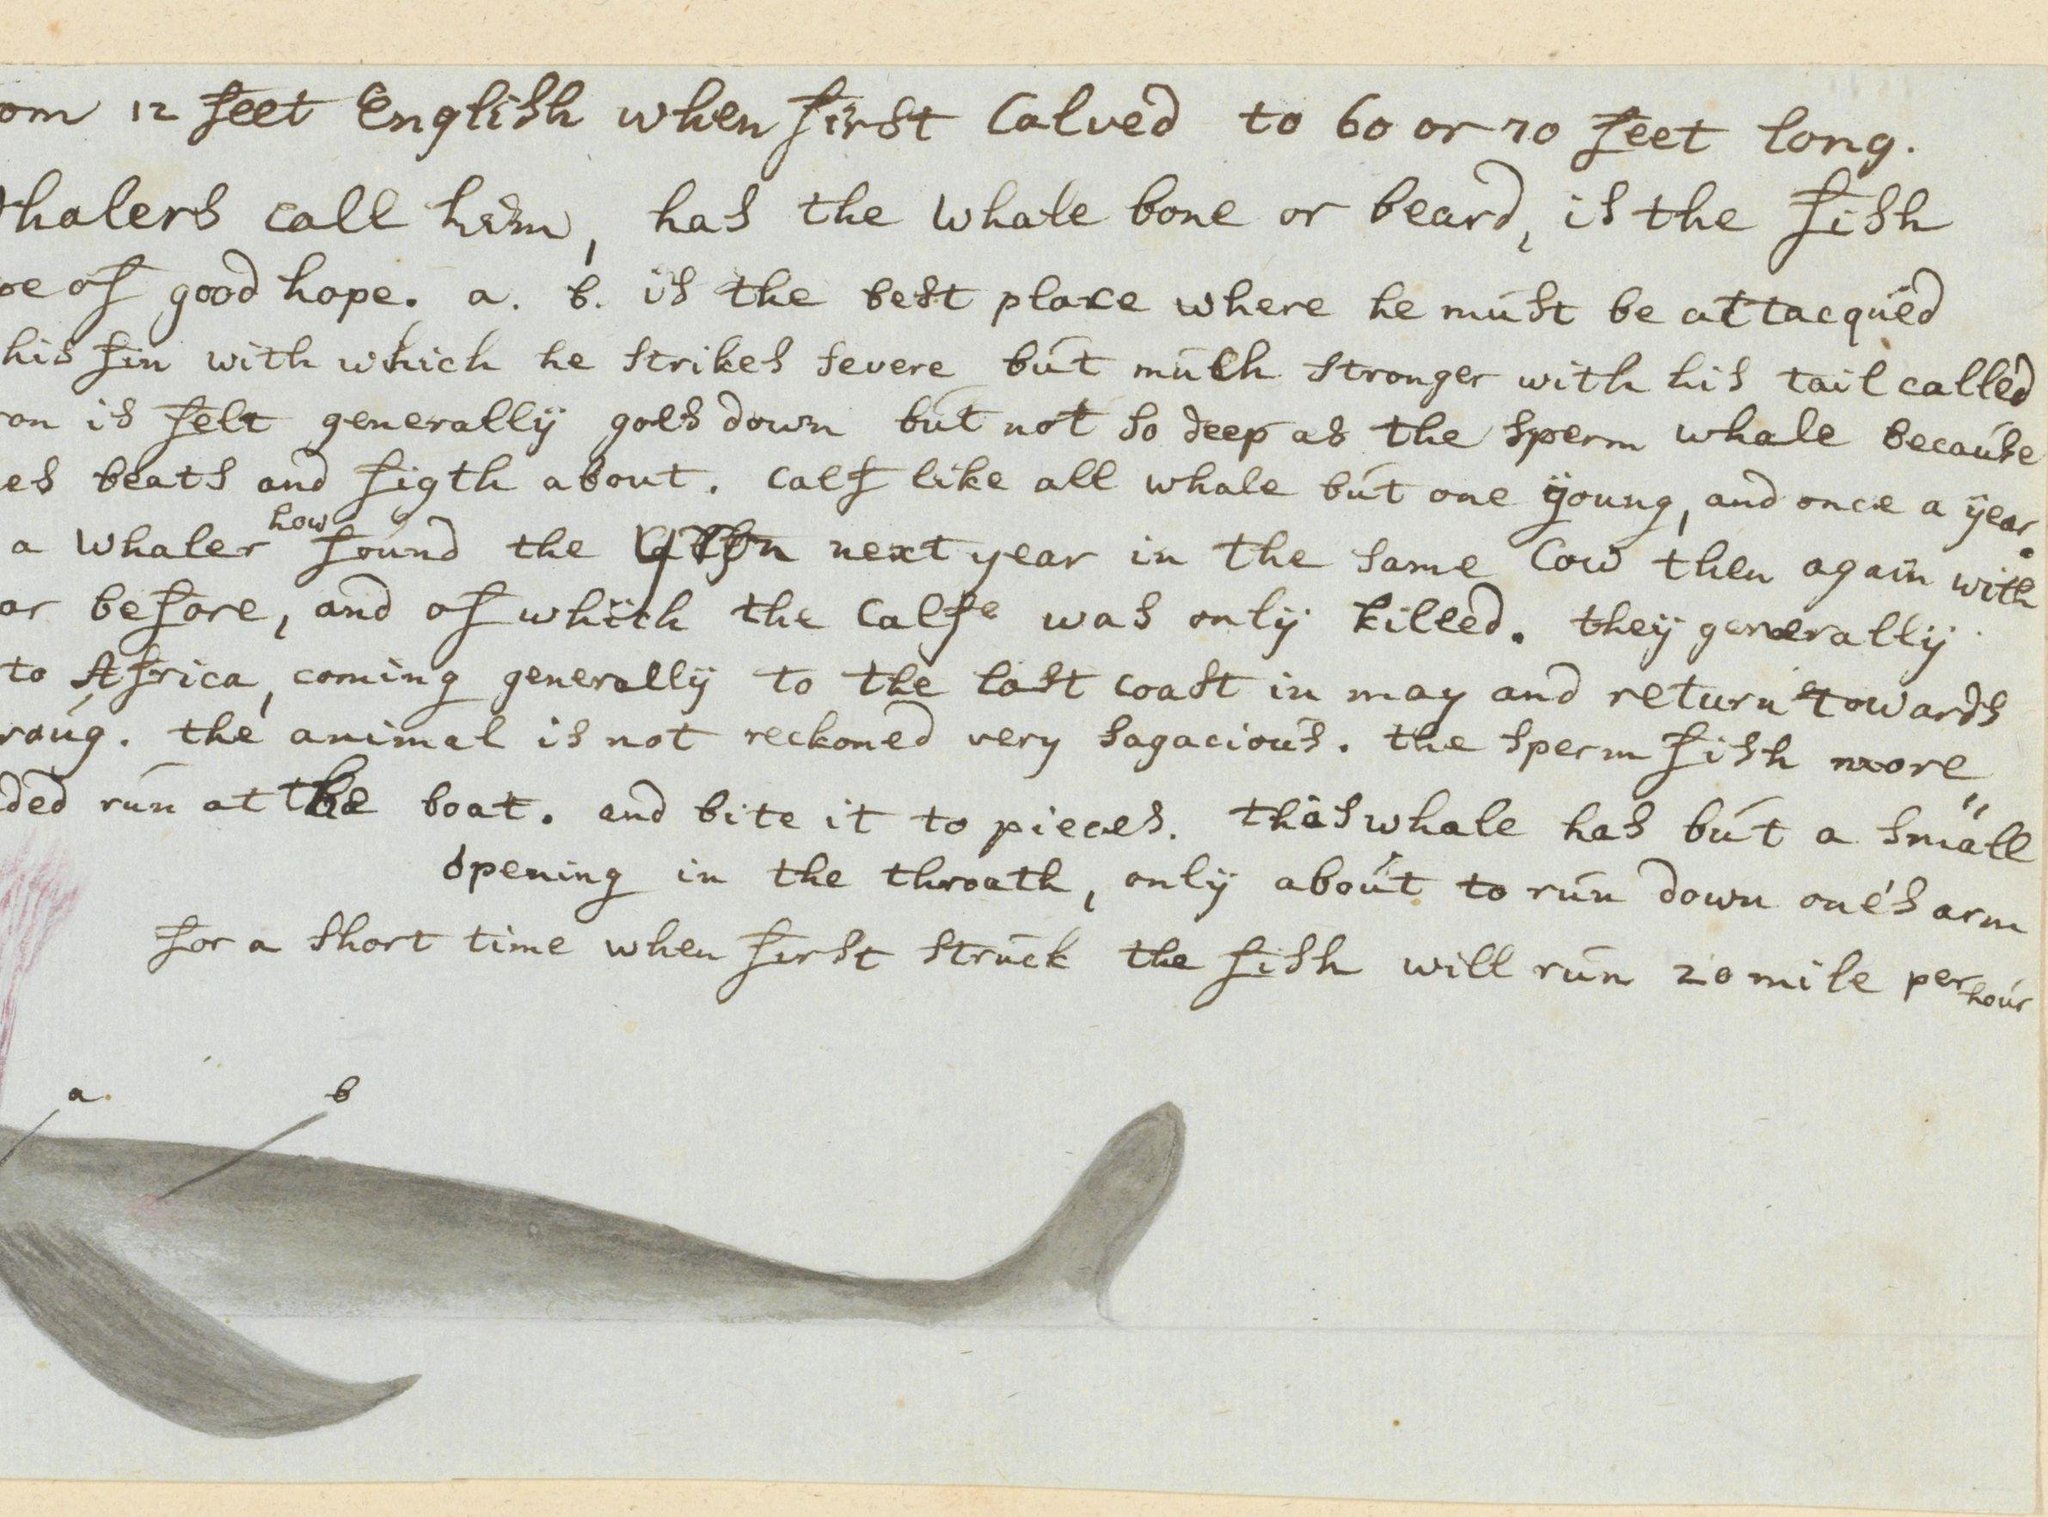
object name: drawing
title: Eubalaena australis (Southern right whale)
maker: robert jacob gordon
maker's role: draughtsman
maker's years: 1743-1795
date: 1773-1786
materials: chalk, ink, paper, pencil, watercolor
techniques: brush, pen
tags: swimming mammals: whale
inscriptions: annotation: ‘l.o.: from Captain Ali. ; bovenaan: the right or black whale [...]’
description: Een zwarte, of echte walvis, volgens Kapitein Ali; komt voor rond de Kaap de Goede Hoop.